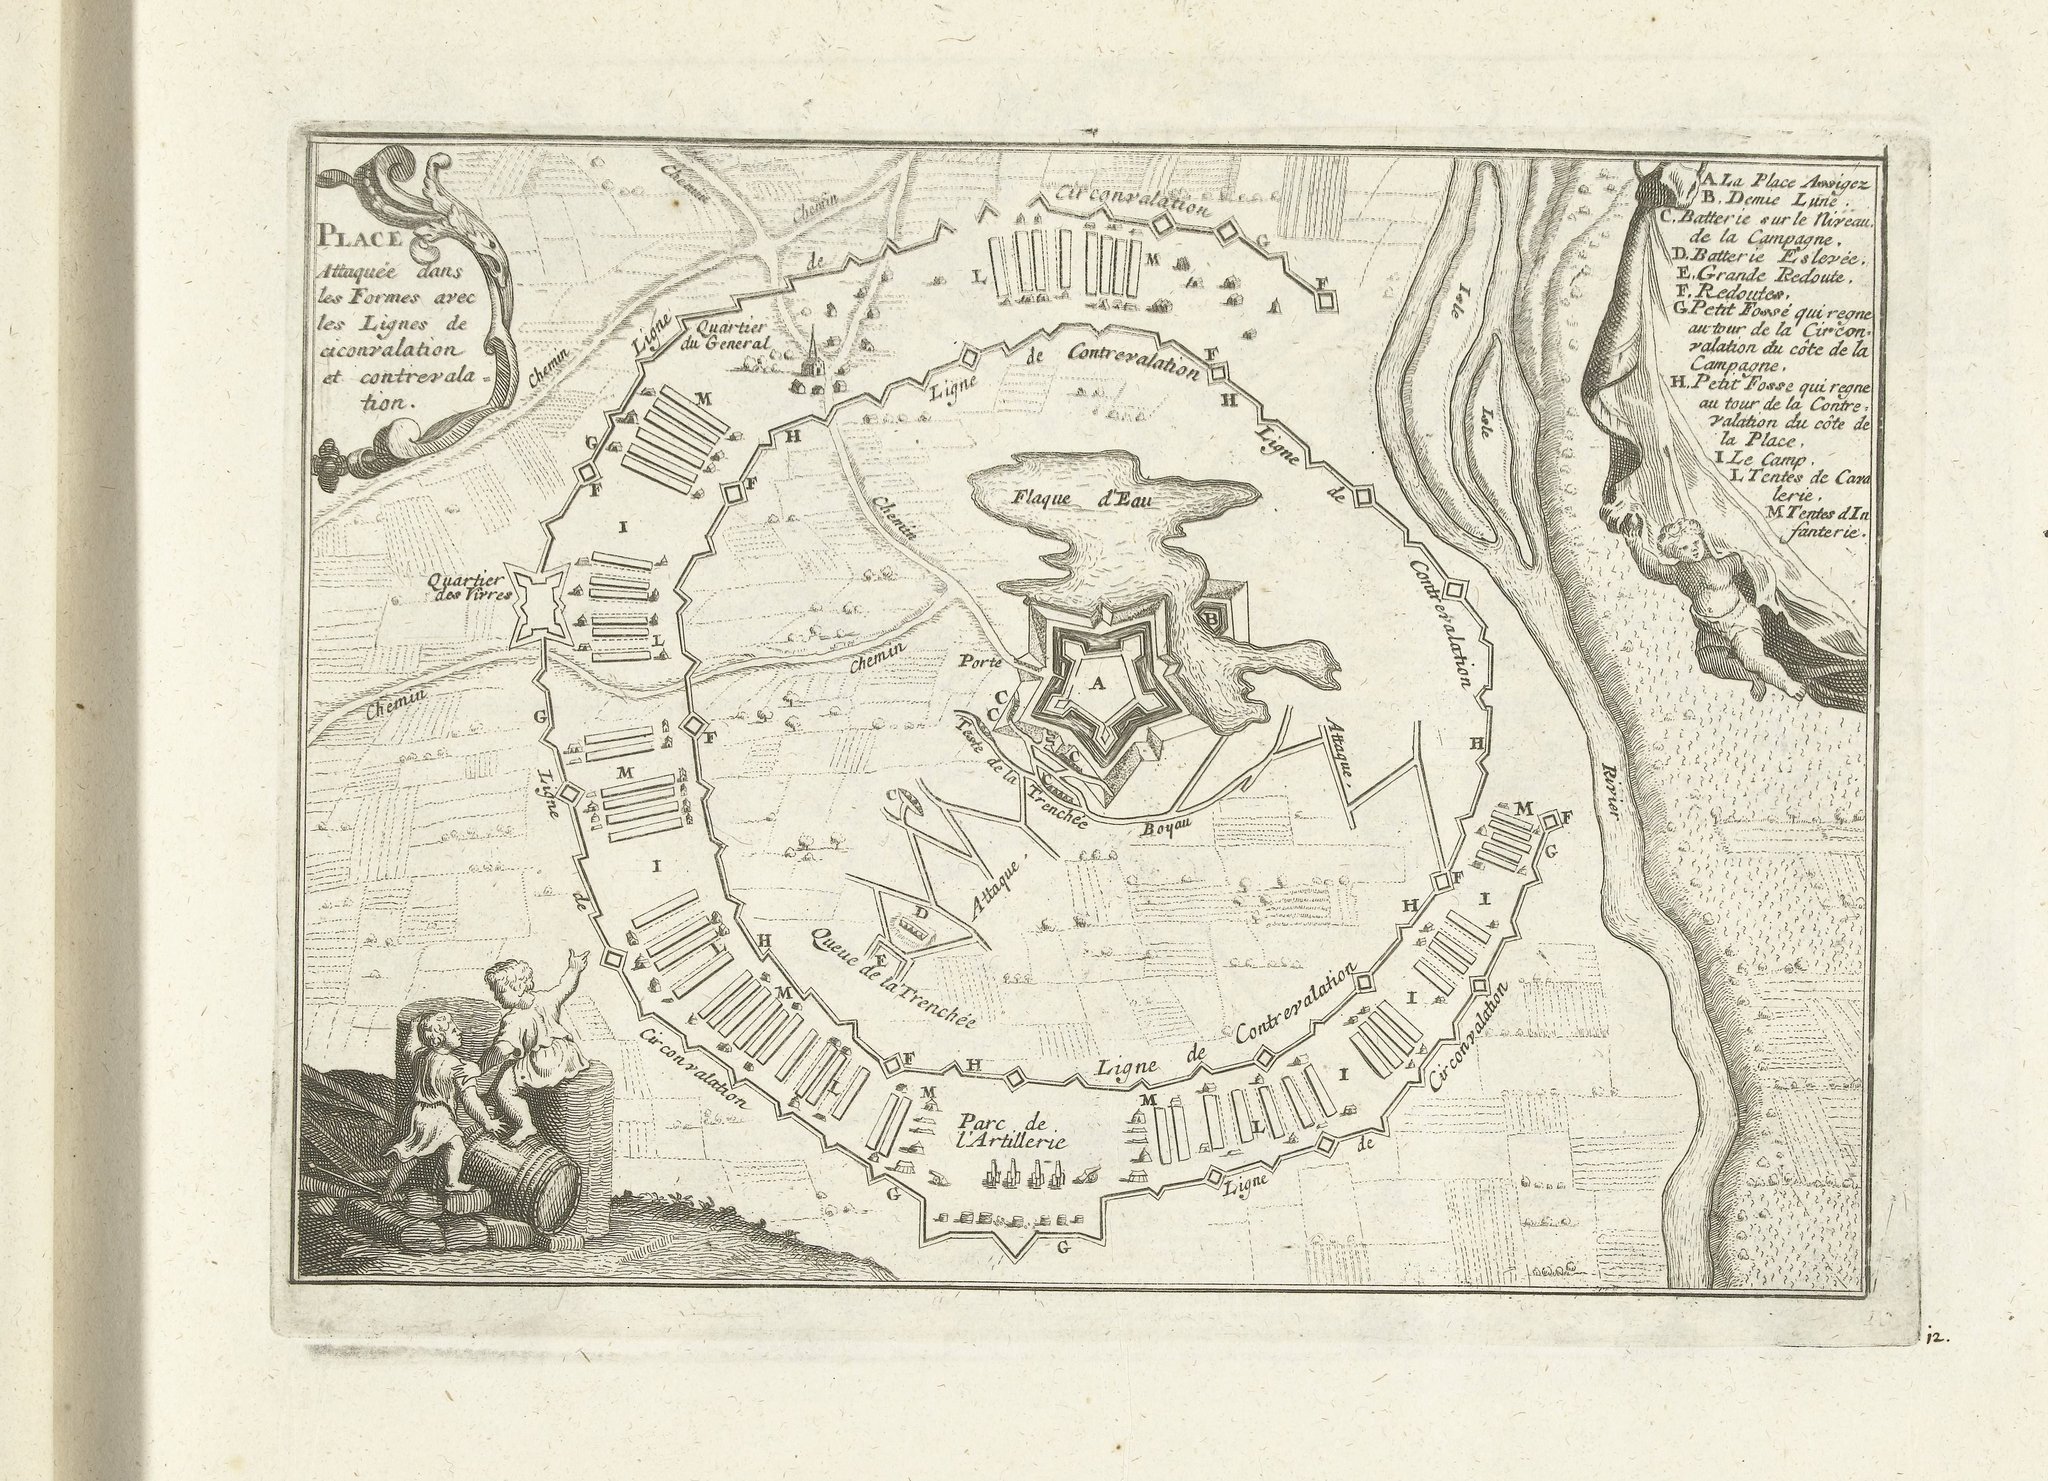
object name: print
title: Place Attaquée dans les Formes avec les Lignes de Ciconvalation et contrevalation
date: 1726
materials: paper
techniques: etching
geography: leiden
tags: fortifications, military engineering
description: Schematische voorstelling van een denkbeeldig beleg. Plaat nr. 12 in deel I van het prentwerk: Les Forces de l'Europe, Asie, Afrique et Amerique ... Comme aussi les Cartes des Côtes de France et d'Espagne uit 1726, dit eerste deel met 238 met de hand genummerde platen van vermaarde sterke steden en vestingen in het kader van de Spaanse Successieoorlog 1701-1713. Voor het merendeel zijn deze platen gekopieerd naar de anonieme Franse platen van vermaarde sterke steden en vestingen: in Les forces de l'Europe en in: Le theatre de la guerre, dans les Pays-Bas, beide oorspronkelijk uitgegeven door Nicolas de Fer te Parijs (1693-1697) in het kader van de Negenjarige Oorlog. Titels en opschriften in het Frans.